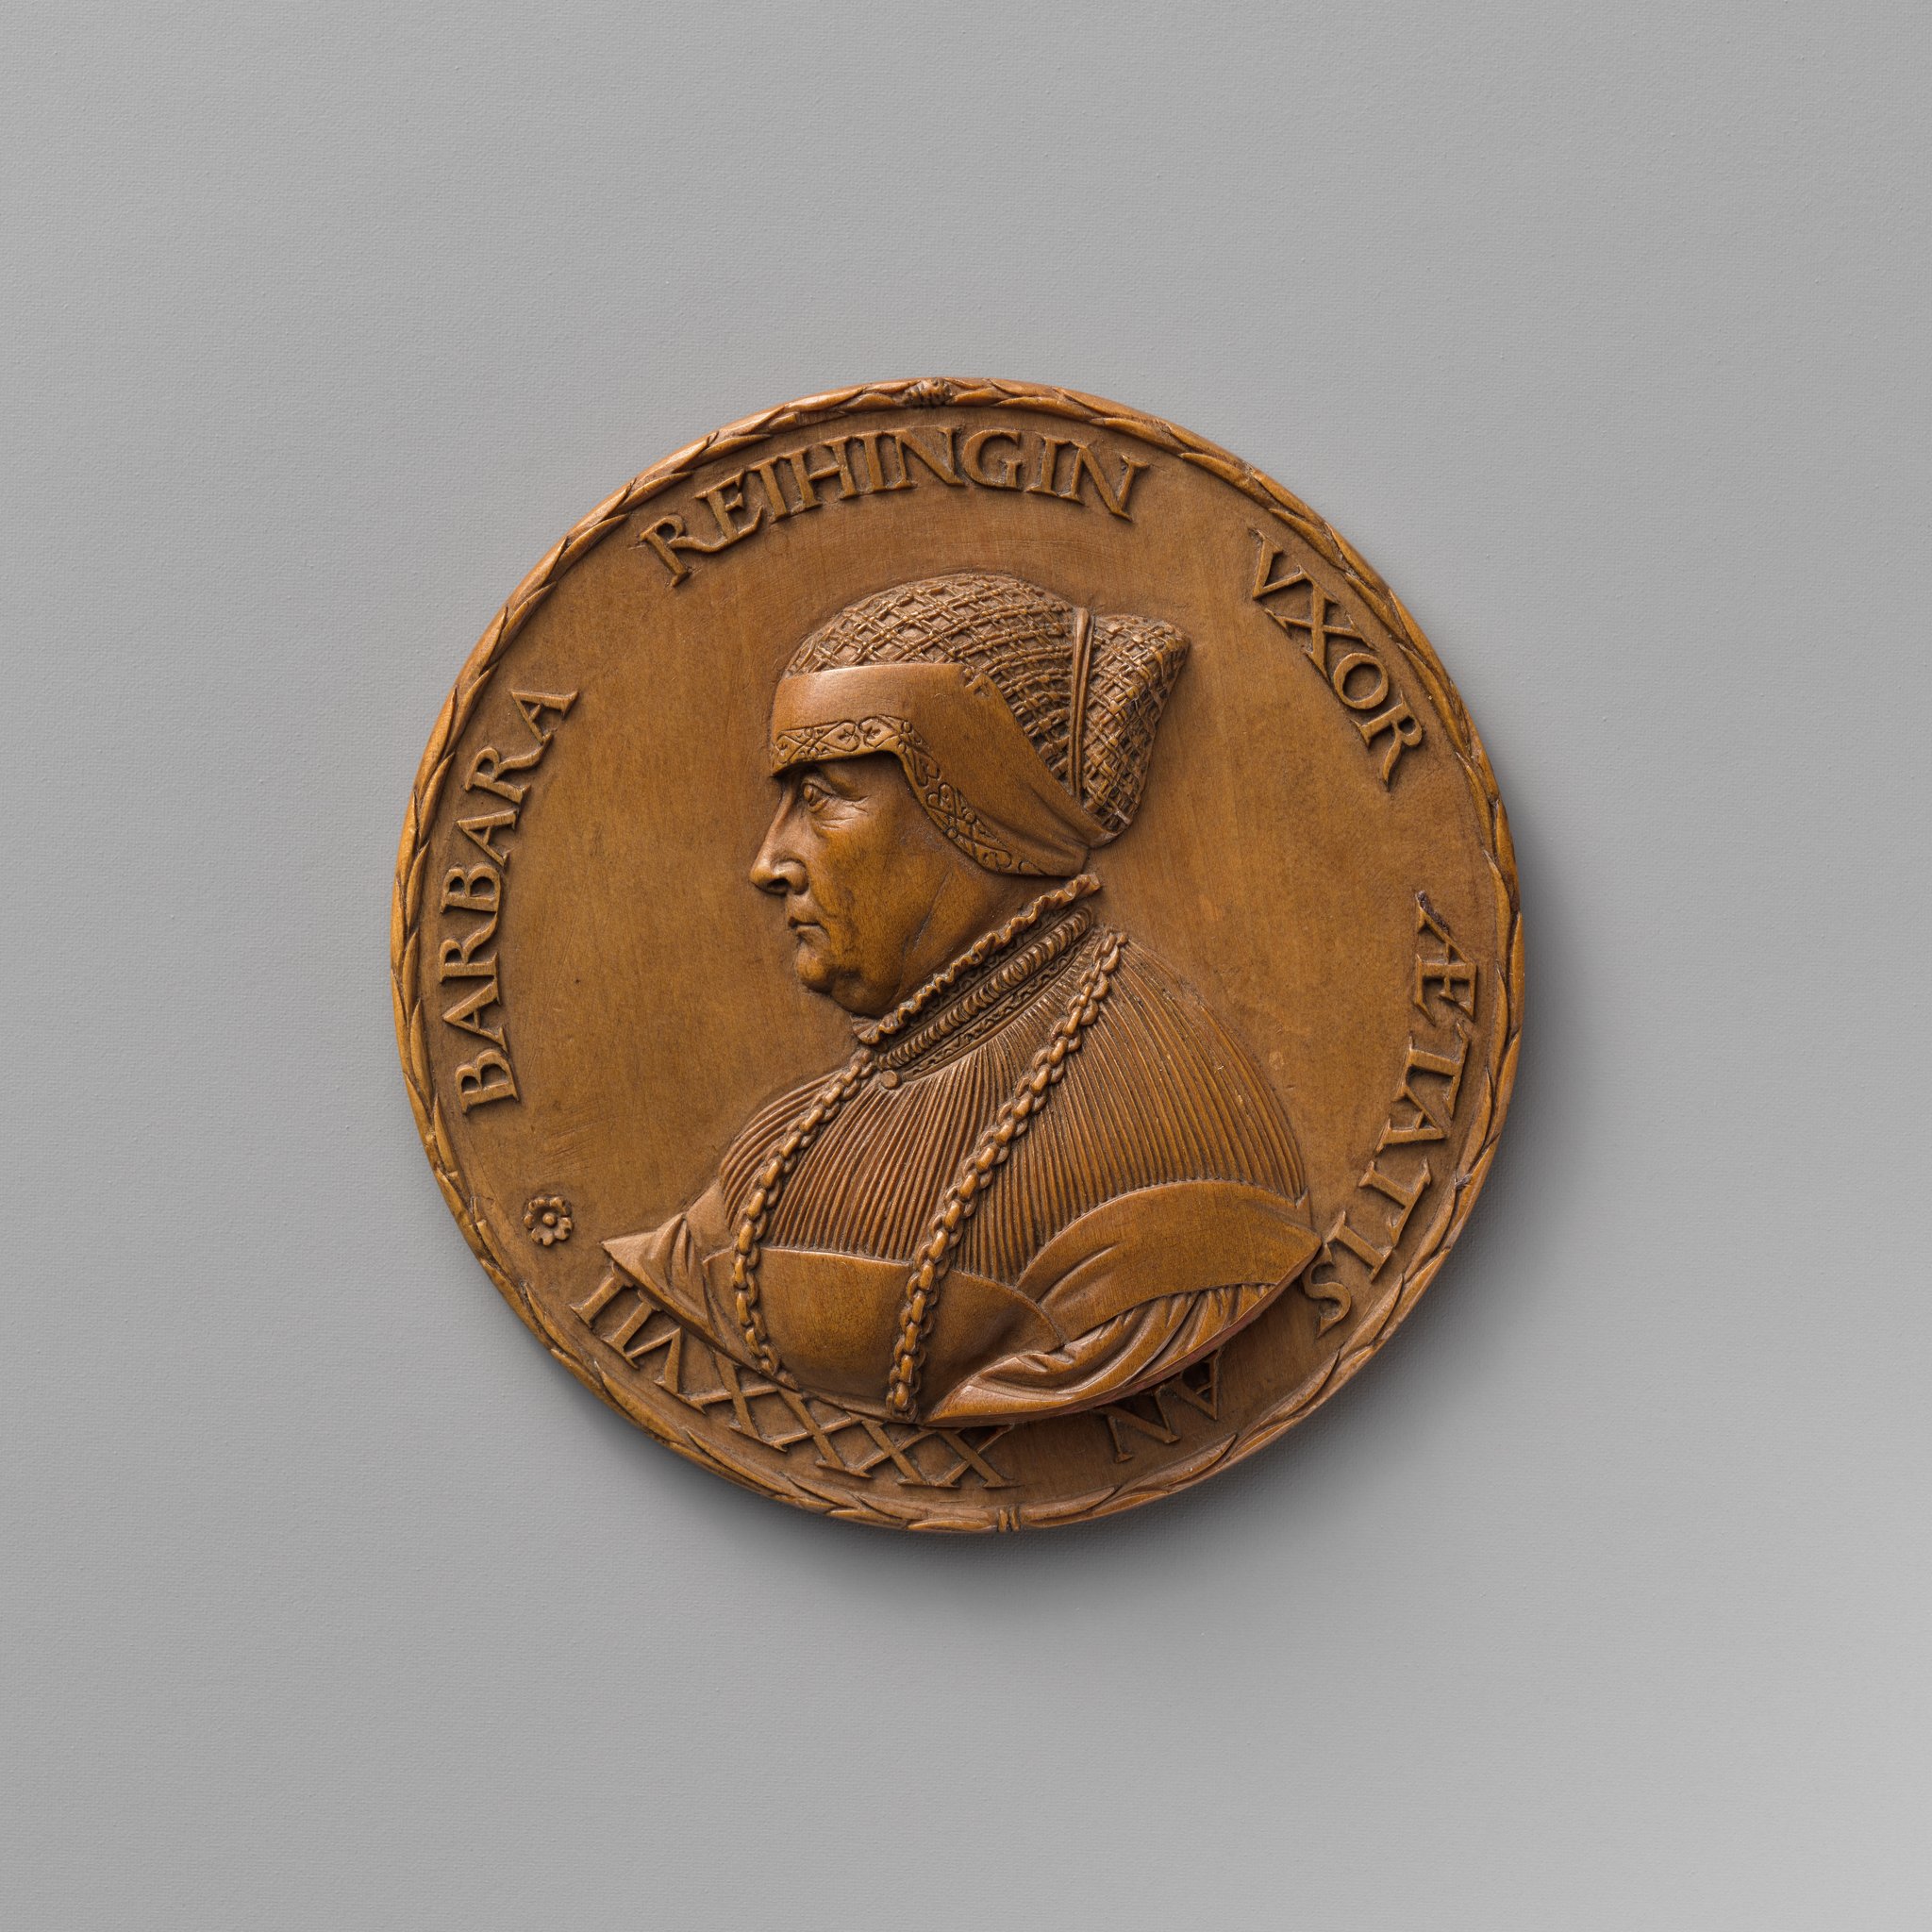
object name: medallion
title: Barbara Reihing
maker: hans kels the younger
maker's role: artist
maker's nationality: german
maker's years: 1508-1565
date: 1538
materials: wood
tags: profiles,women